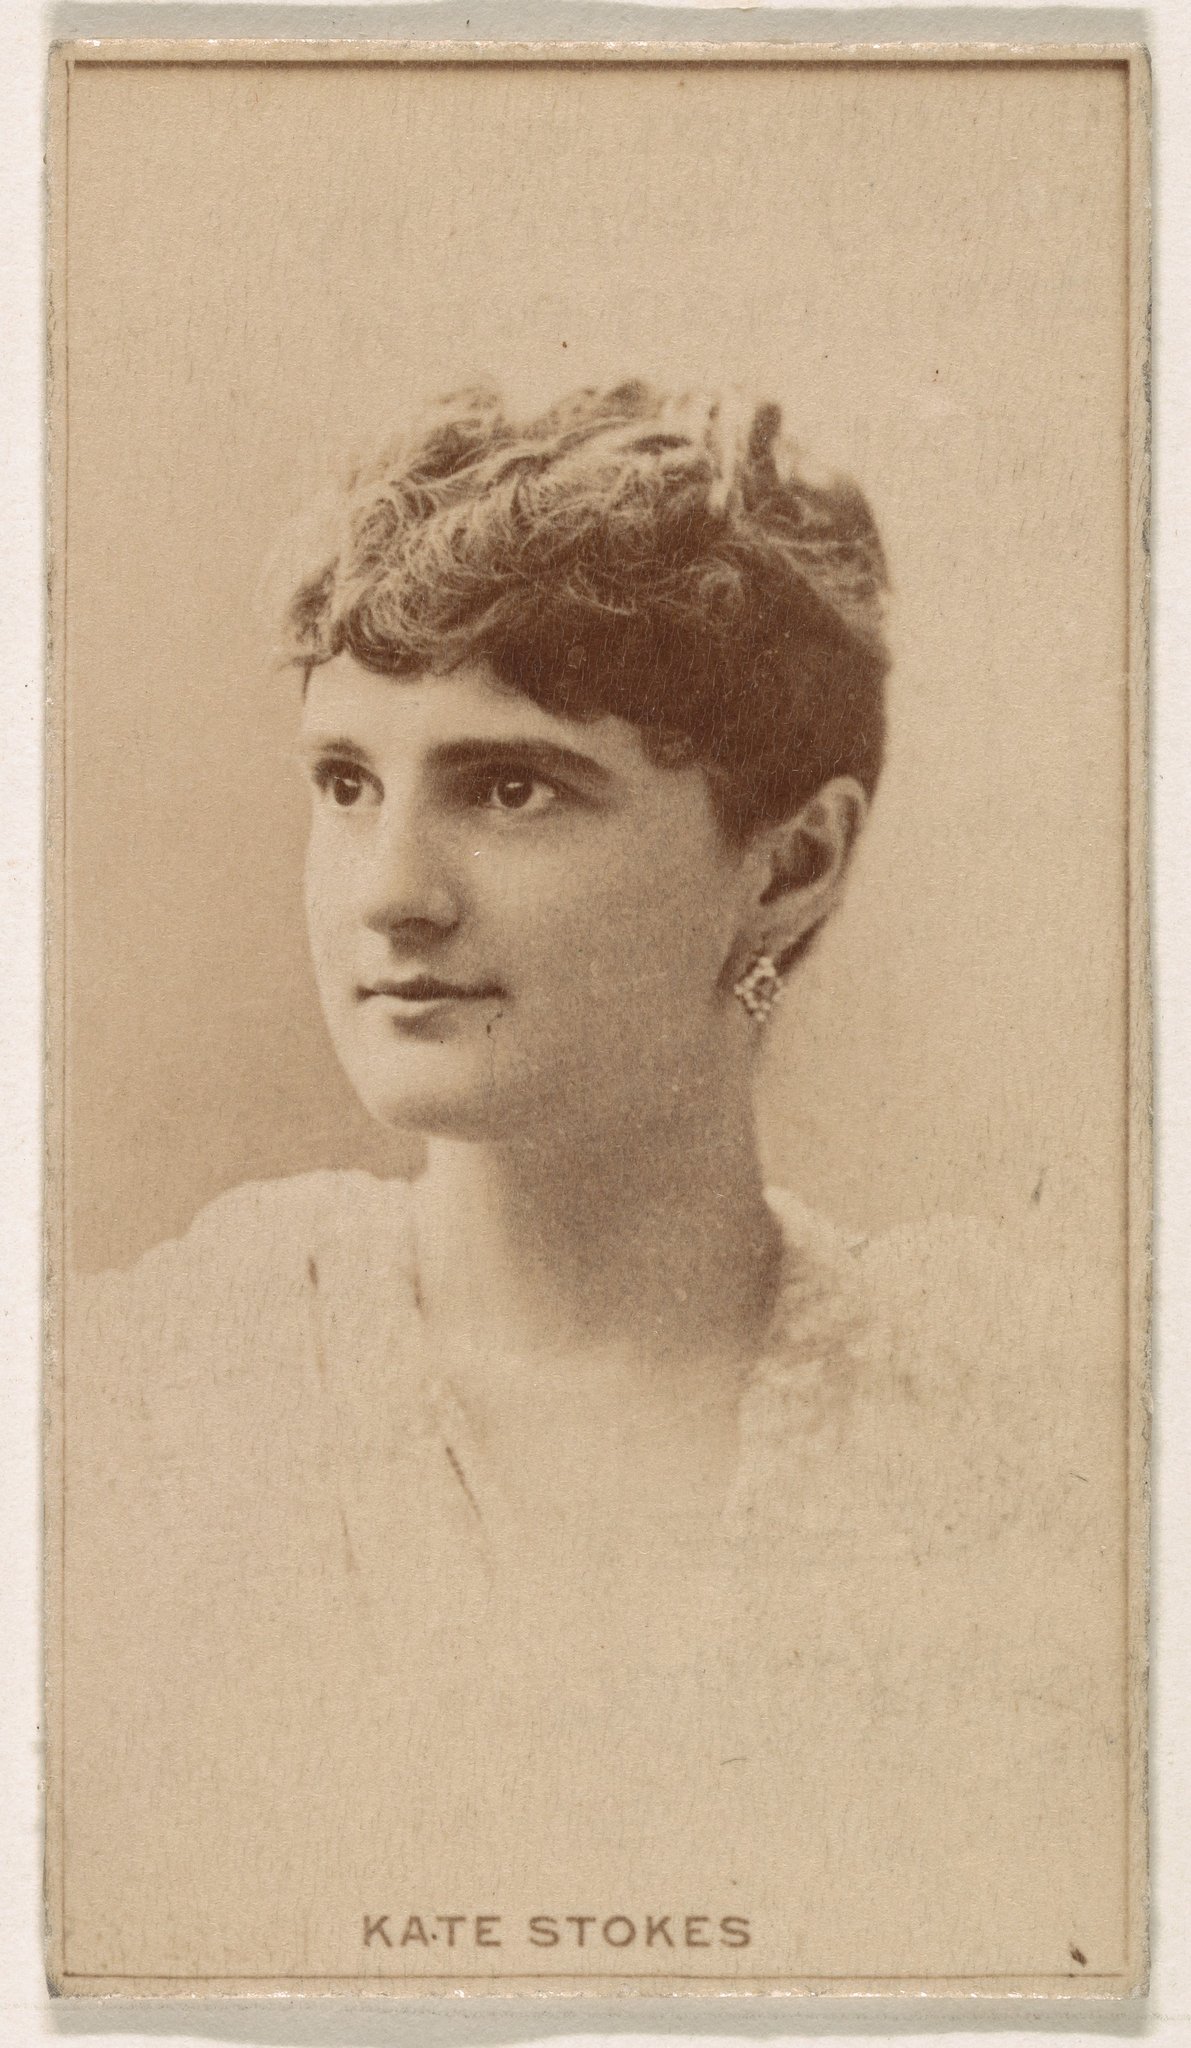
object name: photograph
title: Kate Stokes, from the Actresses series (N245) issued by Kinney Brothers to promote Sweet Caporal Cigarettes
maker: kinney brothers tobacco company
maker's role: publisher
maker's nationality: american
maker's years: 1869-2011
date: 1890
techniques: albumen silver print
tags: portraits,women,actresses